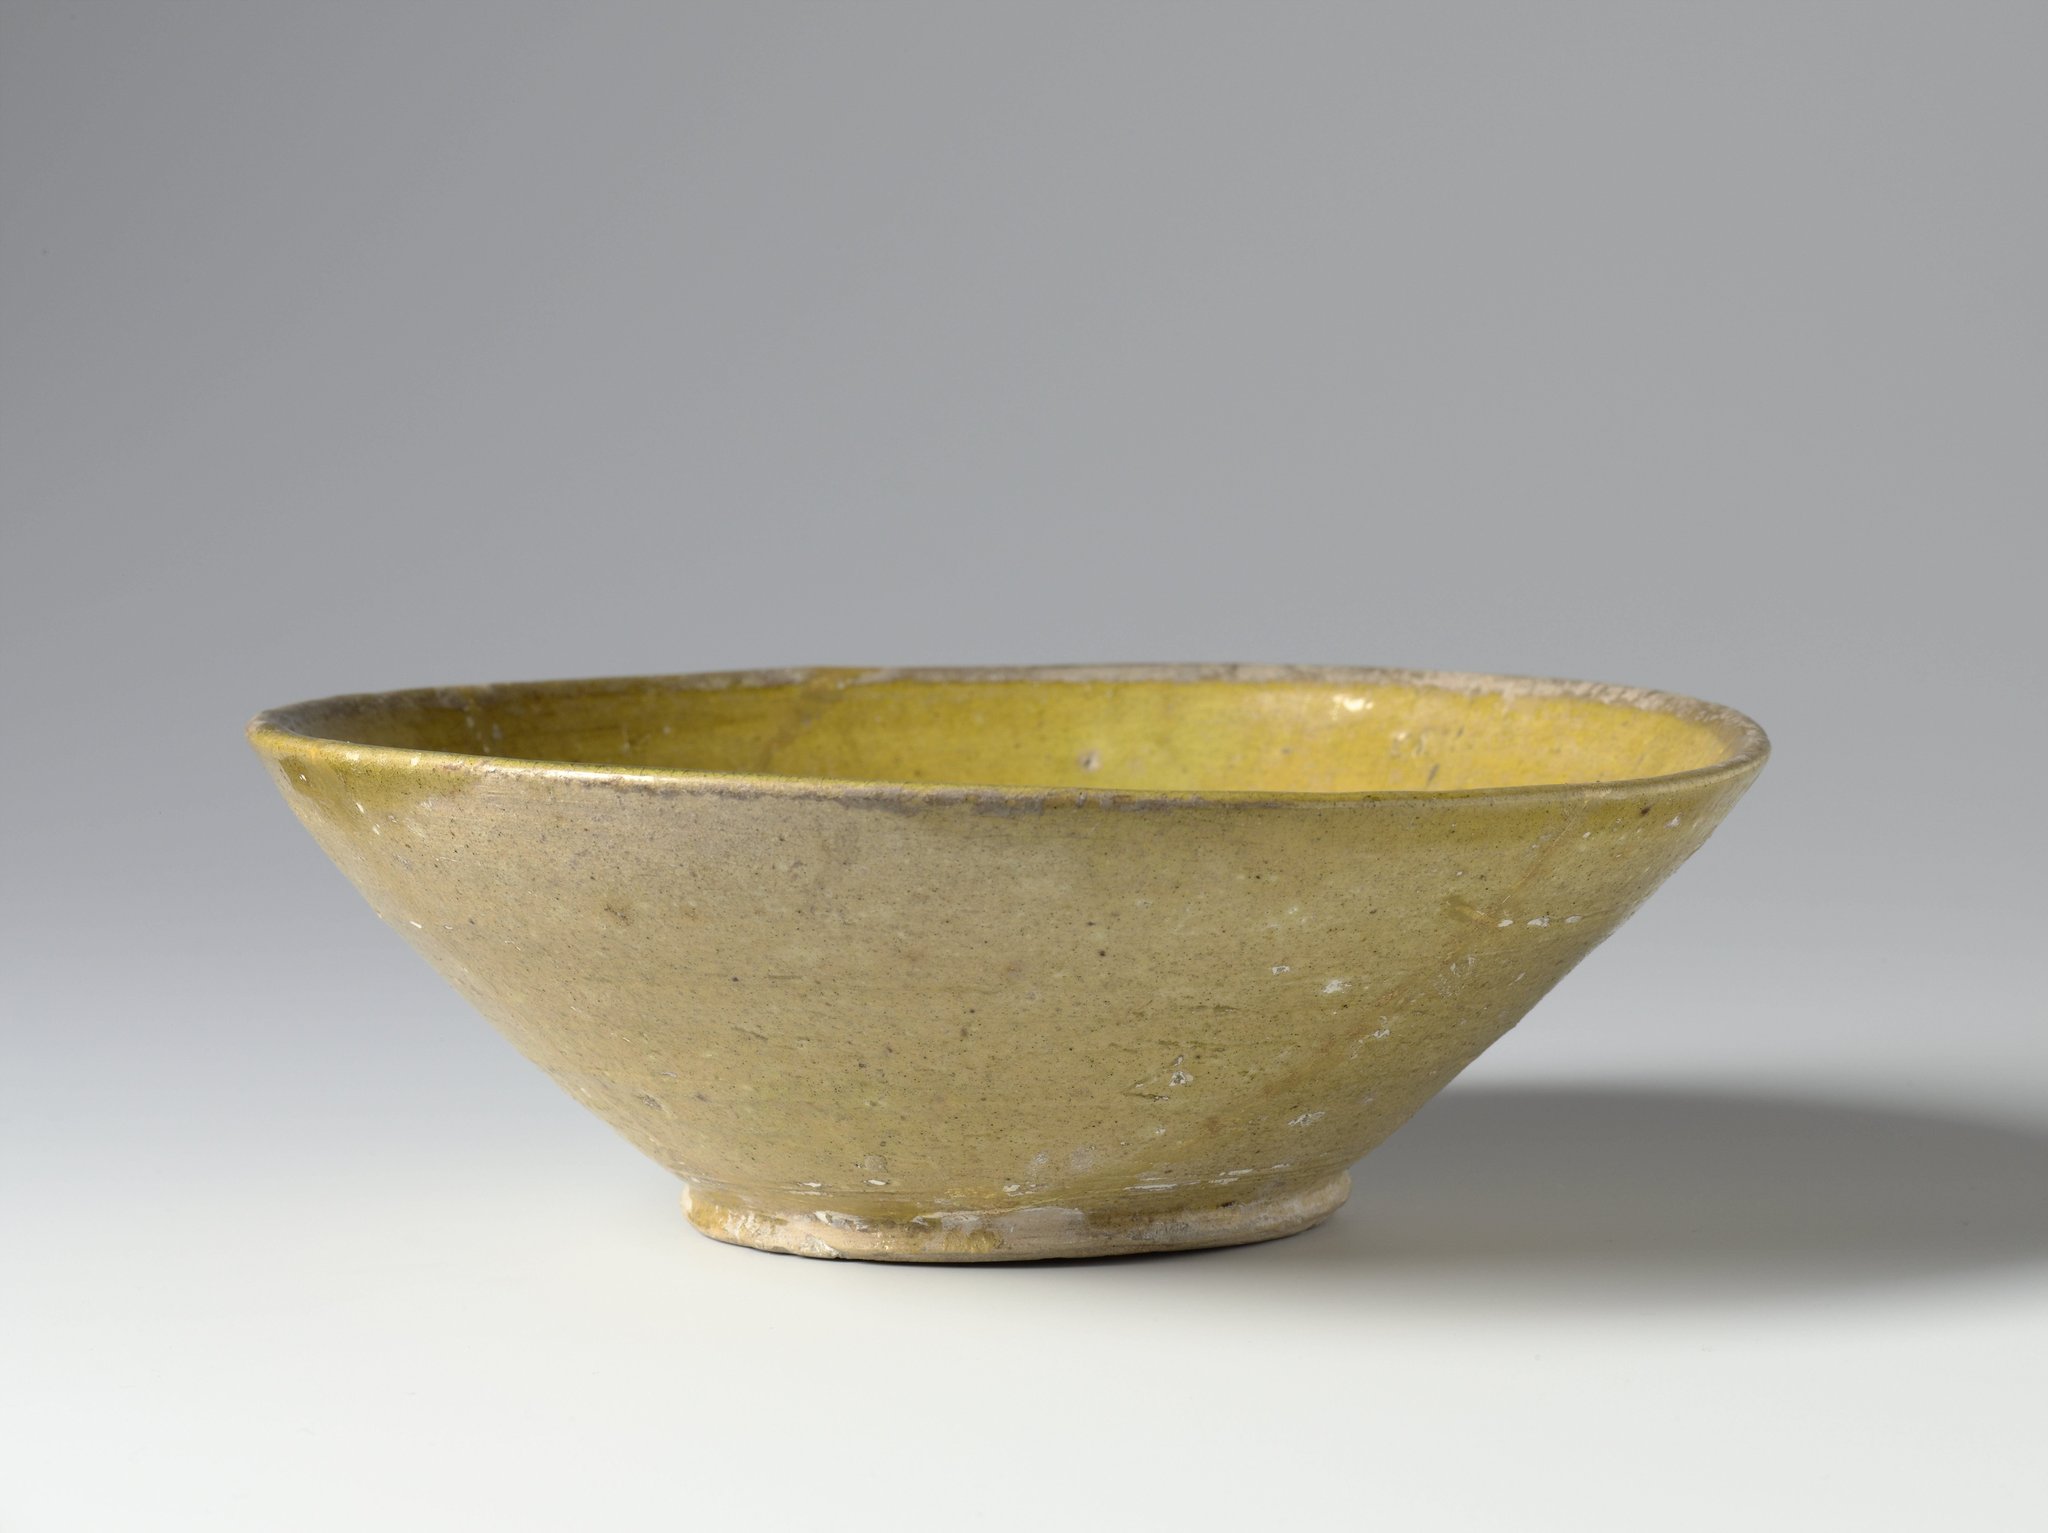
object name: bowl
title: Bowl with a yellow slip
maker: Anonymous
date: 900-1099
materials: earthenware, glaze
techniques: firing, turning, vitrification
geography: nishapur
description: Kom van aardewerk bedekt met een gele slib een een transparant lood glazuur.